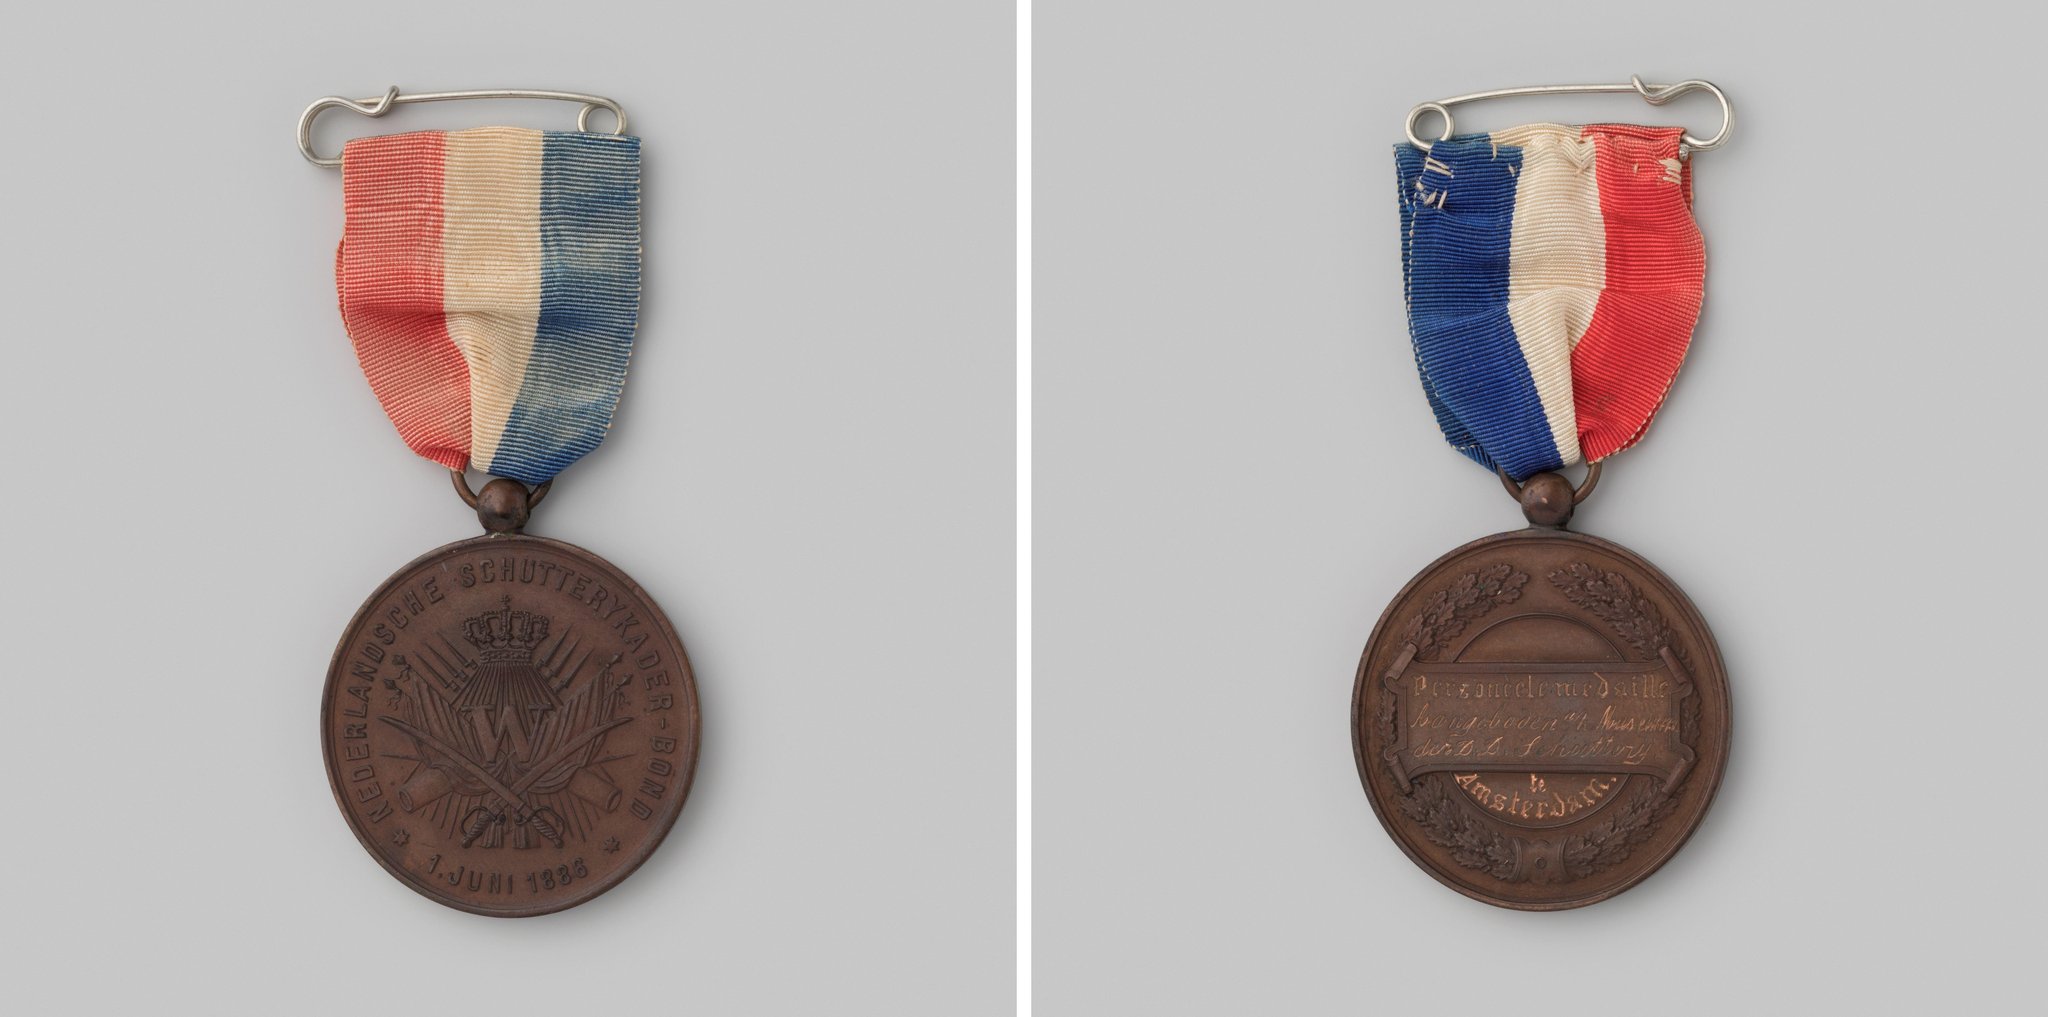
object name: history medal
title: Afslag van een prijspenning (personeele-medaille) van de Nederlandsche Schutterij-Kaderbond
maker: Anonymous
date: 1886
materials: bronze, metal, textile